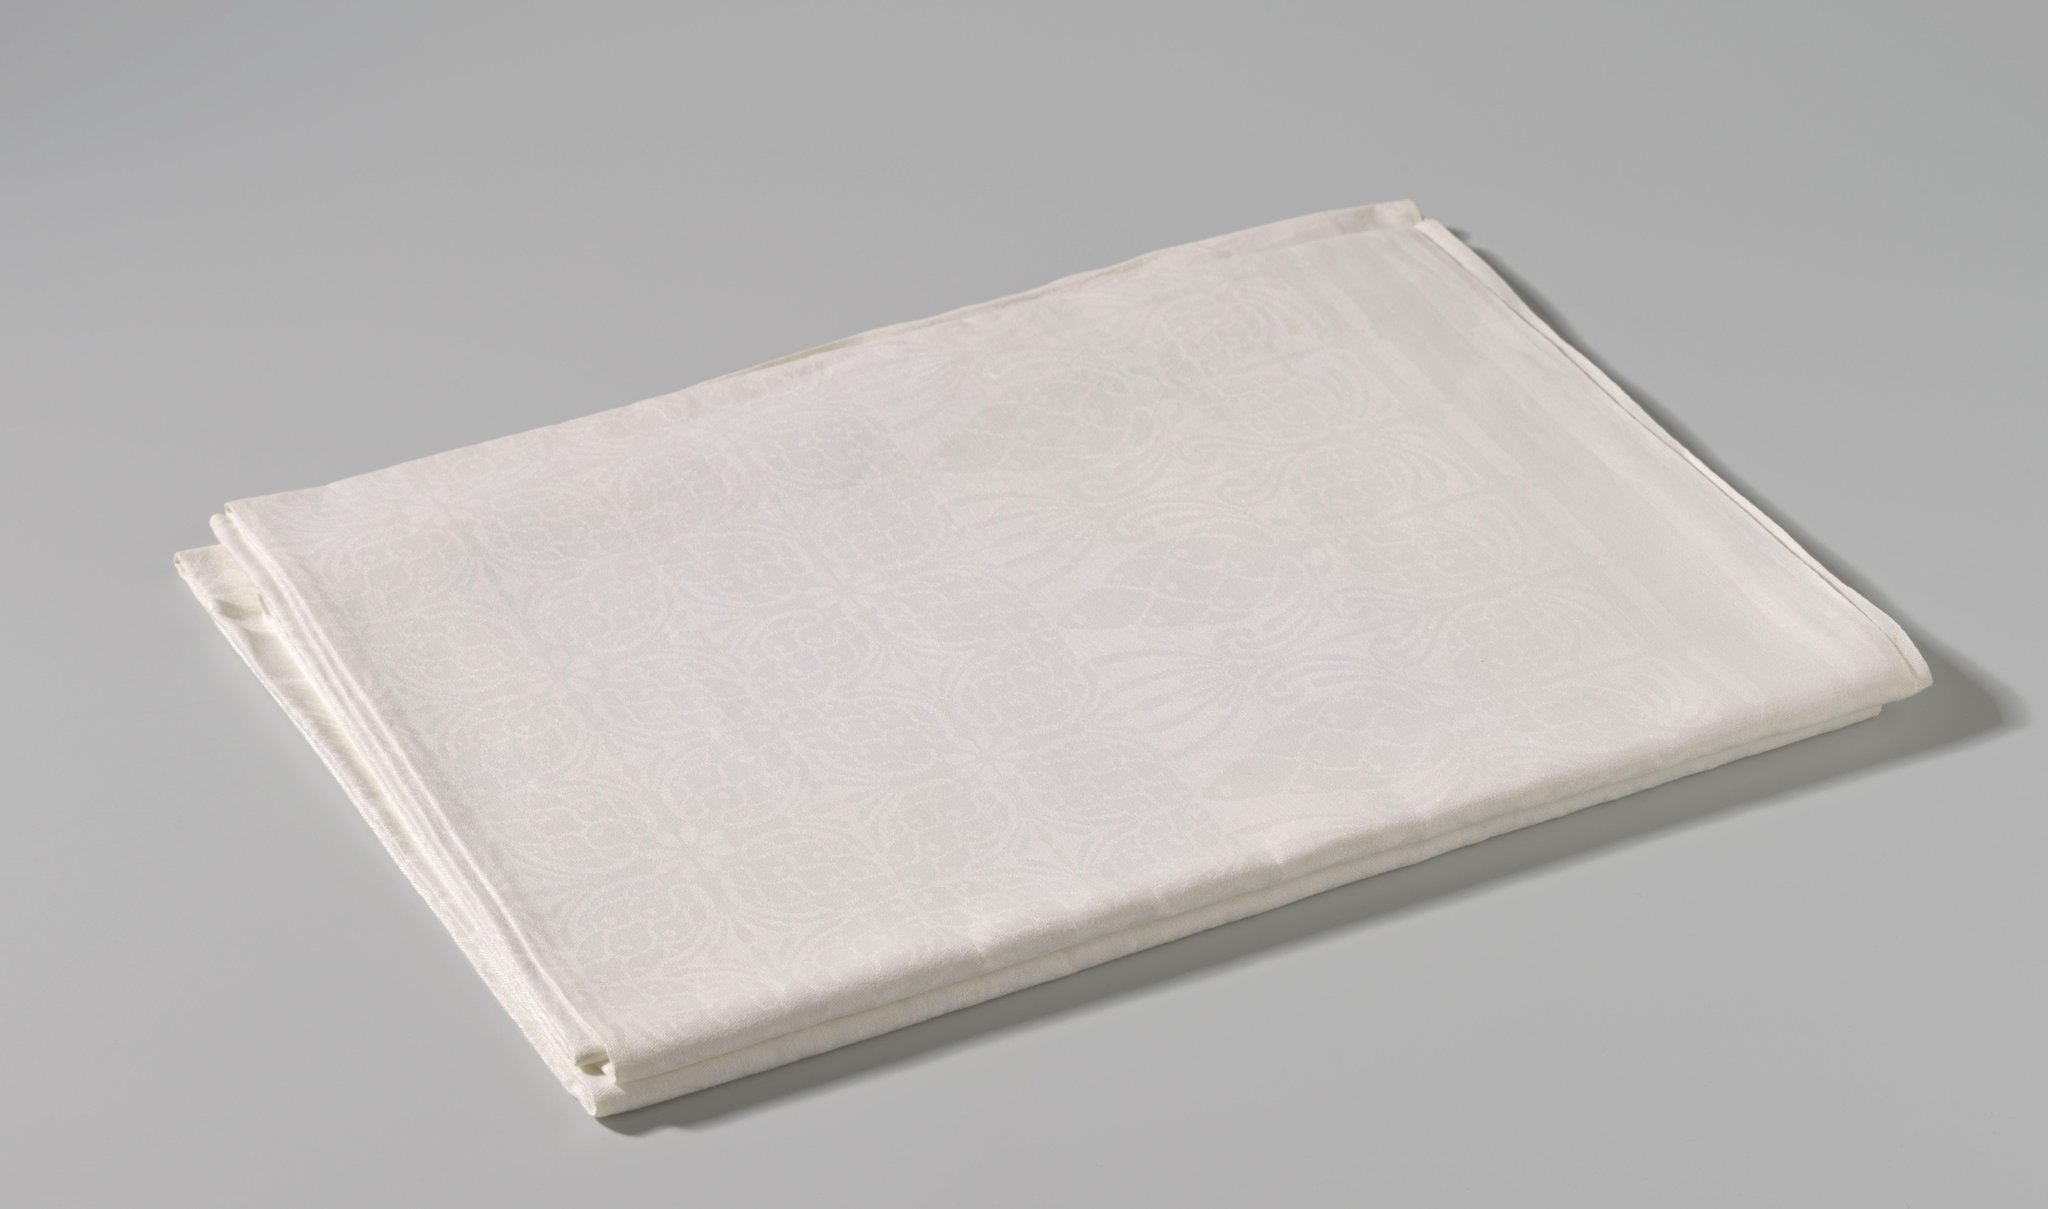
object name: tablecloth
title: Tafellaken van linnendamast motief Naaldenveld, dessin 607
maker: chris lebeau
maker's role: draughtsman, print maker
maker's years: 1878-1945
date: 1900-1925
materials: linen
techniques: damask, weave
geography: netherlands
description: Tafellaken van linnendamast. Motief Naaldenveld, dessin 607. Het tafellaken hoort bij twaalf vingerdoeken (BK-1973-179-A t/m BK-1973-179-L).